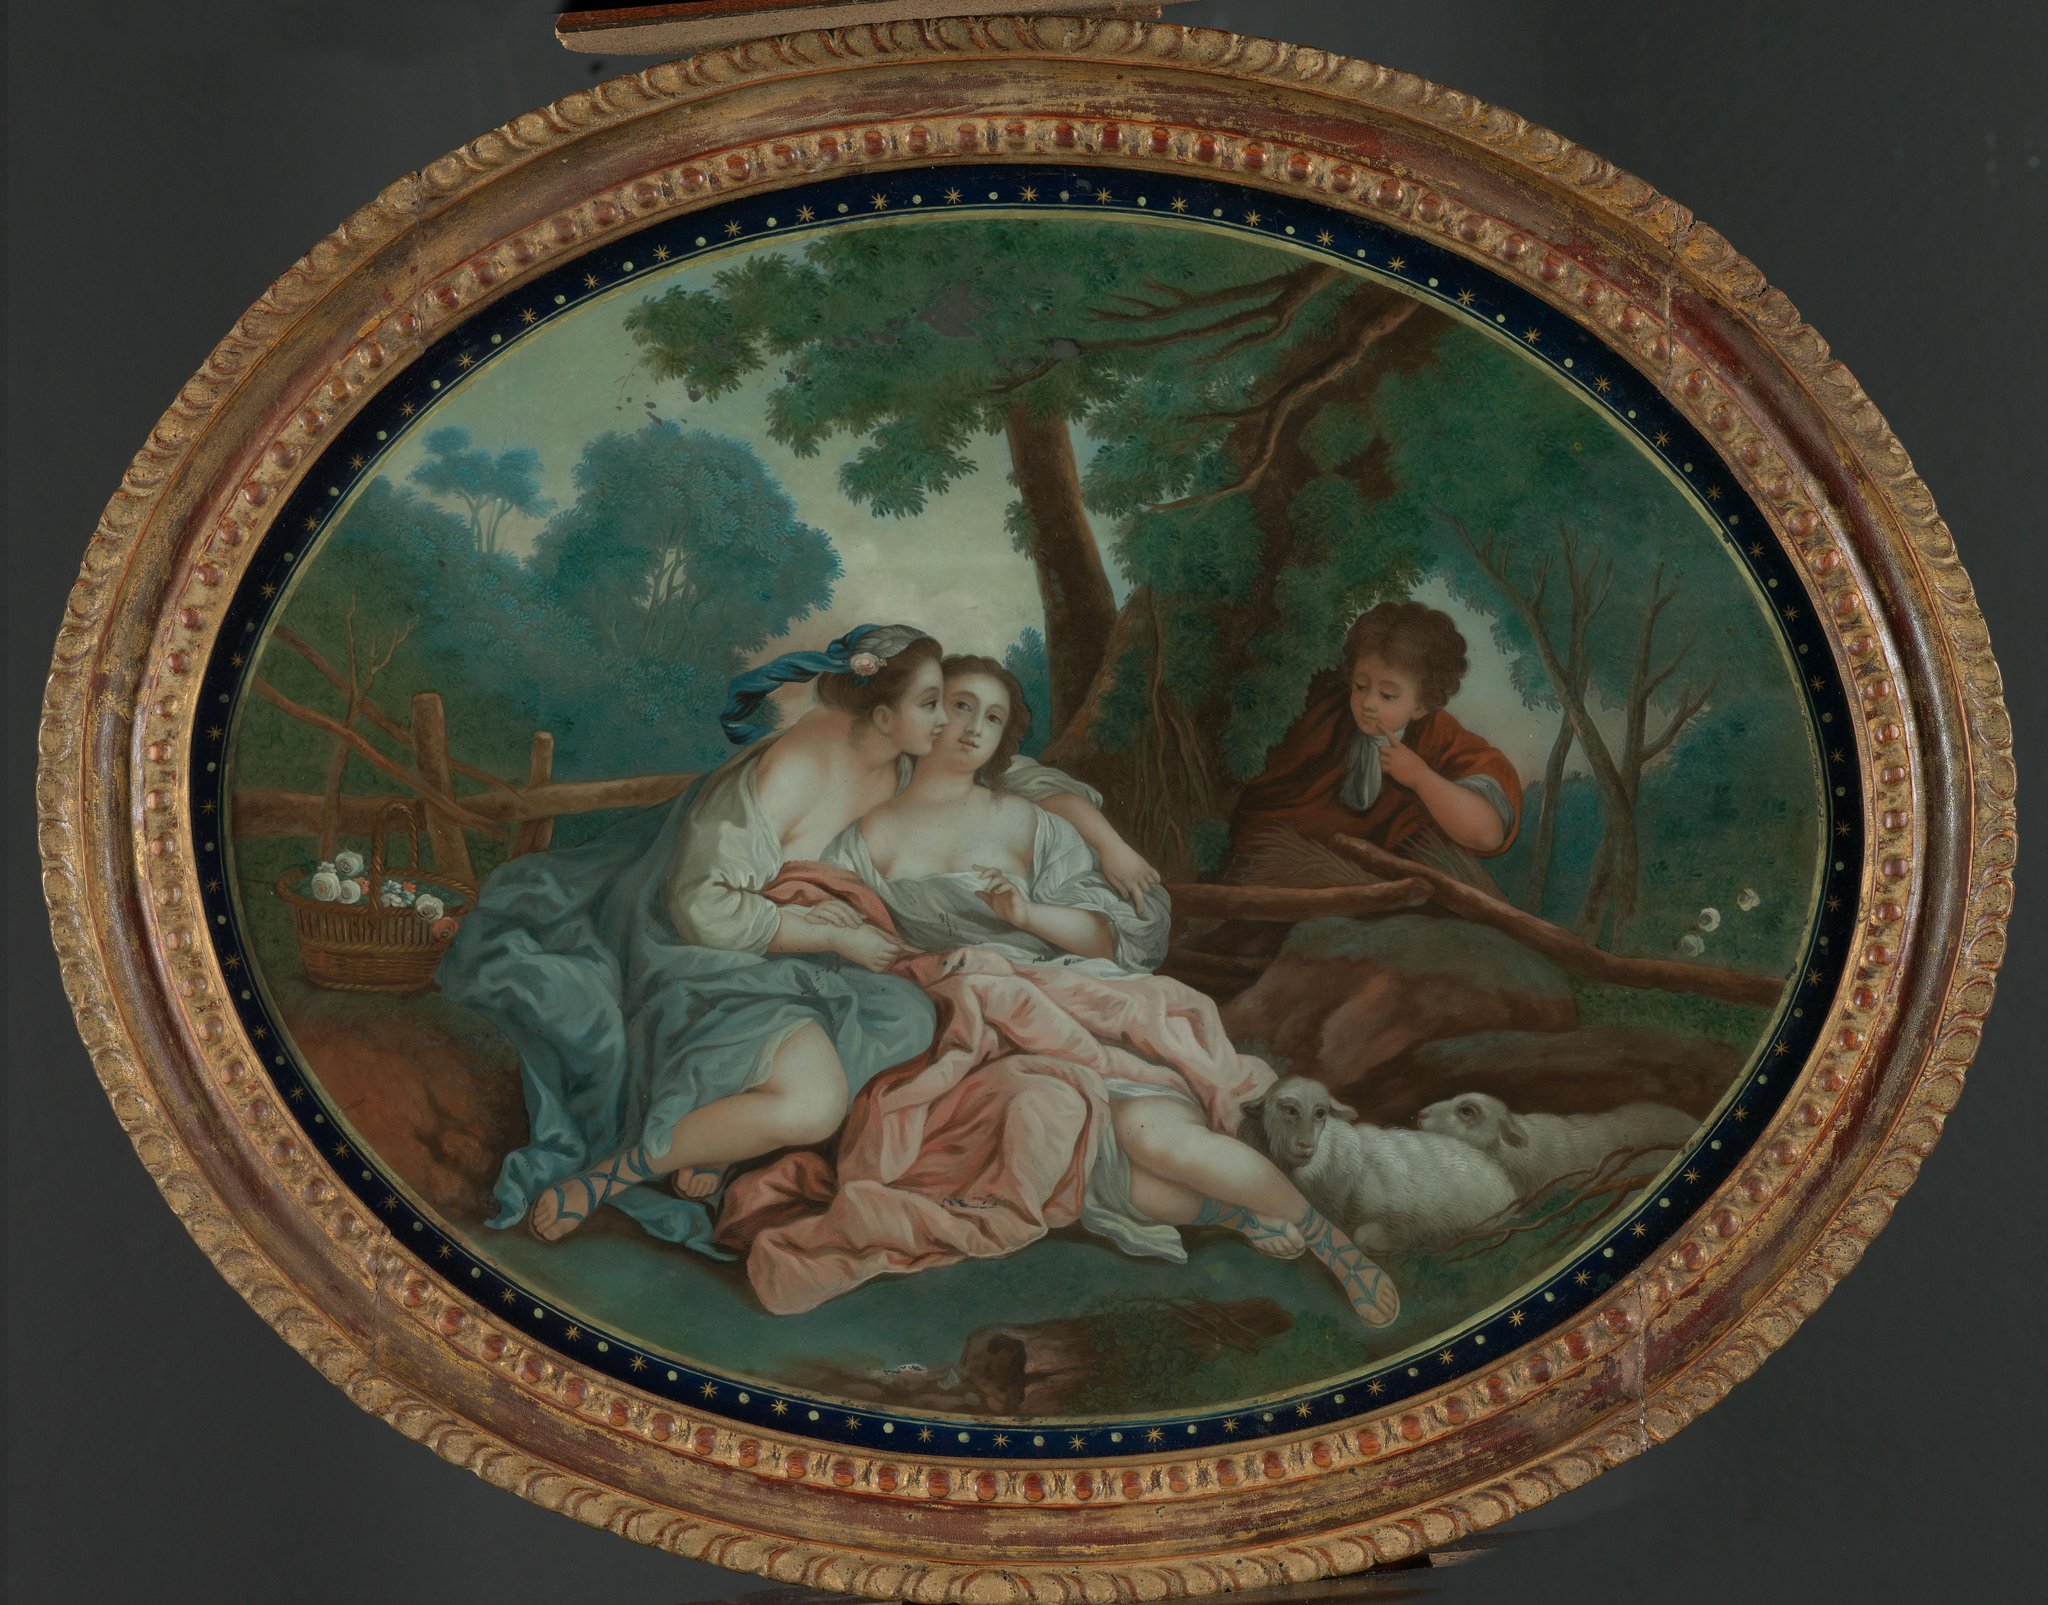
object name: reverse painting on glass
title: Fête galante scene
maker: Anonymous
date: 1795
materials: glass, oil, paint, wood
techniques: cutting, gilding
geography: guangdong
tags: (scenes from) specific works of literature: tasso, aminta, (lovers) embracing each other, 'symplegma', pastorals, arcadian scenes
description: Ovale achterglasschildering met twee dames, twee schapen en een jongen in een landschap die een scène uit het toneelstuk L'Aminta van Torquato Tasso verbeelden: Silvie guérit Philis de la piquure d'une abeille. Naar een prent van Louis Simon Lempereur naar een schilderij van François Boucher. In een originele lijst.